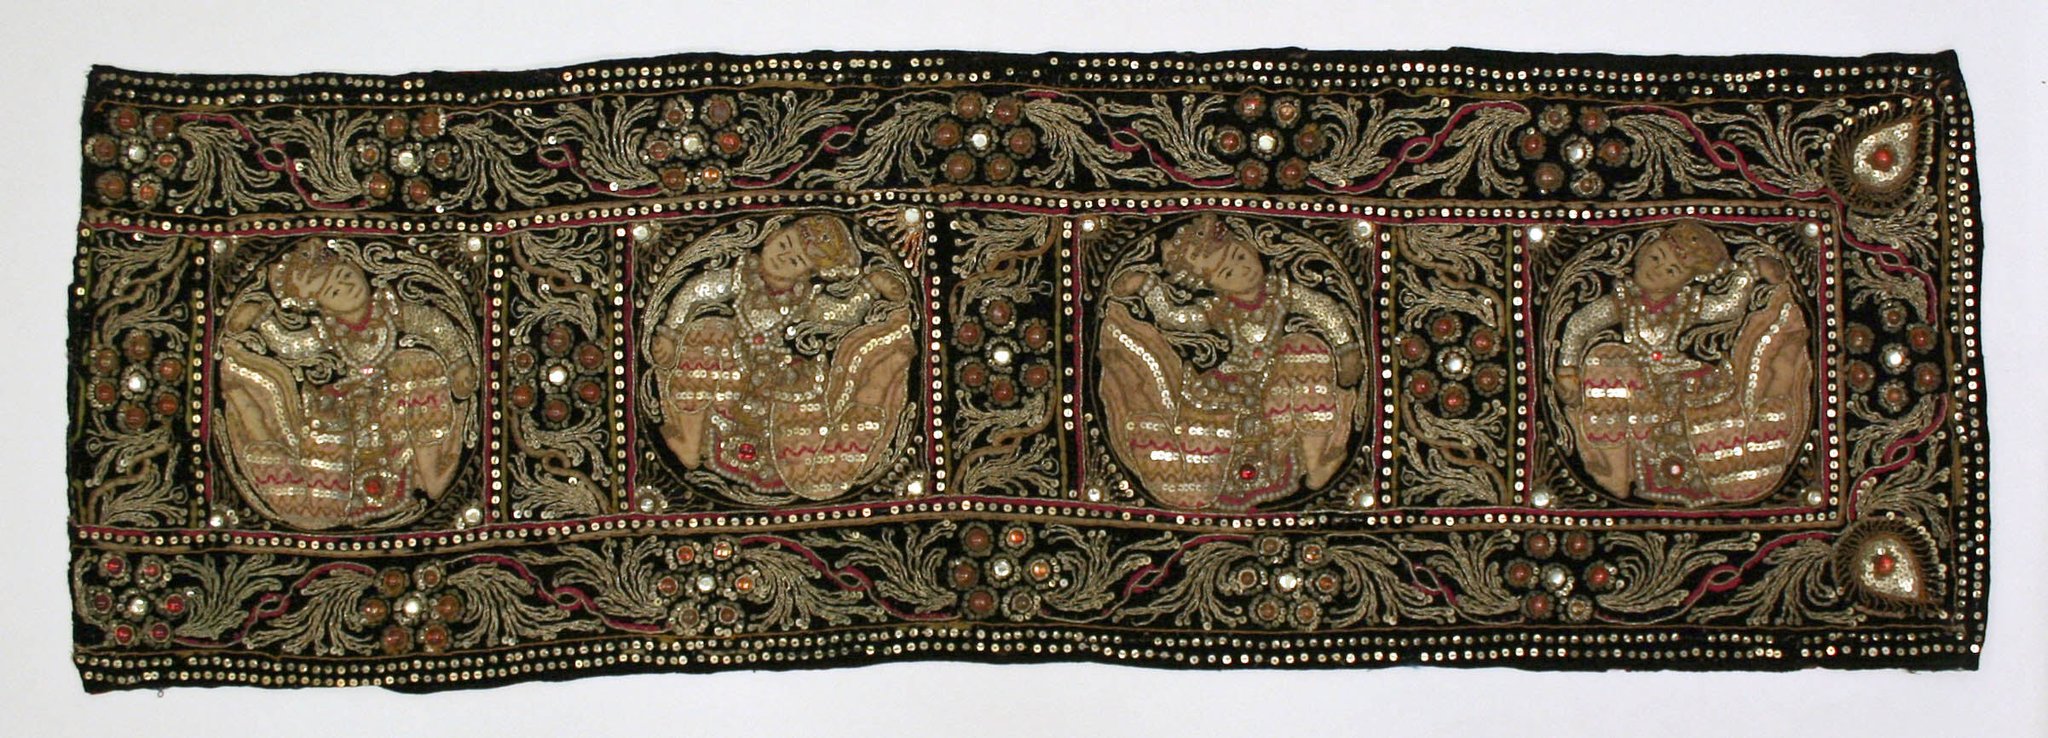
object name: textile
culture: burmese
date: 1801-1900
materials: cotton, glass, metal, silk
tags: human figures